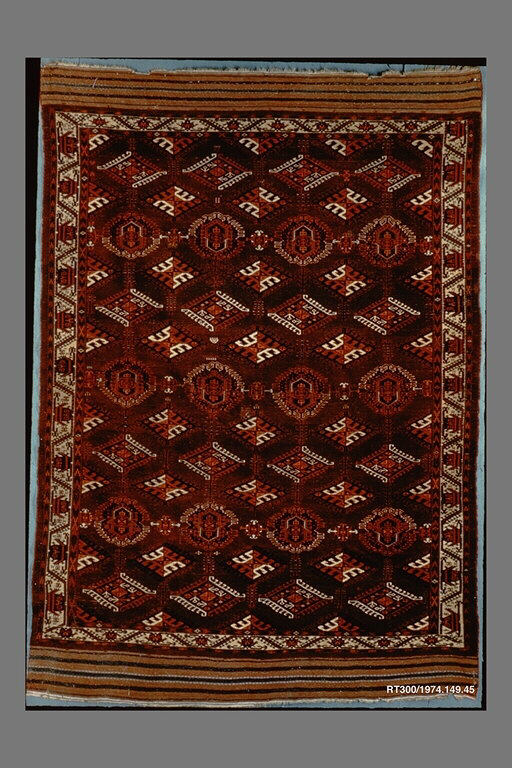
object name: carpet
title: Yomut Main Carpet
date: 1801-1850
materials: wool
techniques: asymmetrically knotted pile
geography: western turkmenistan